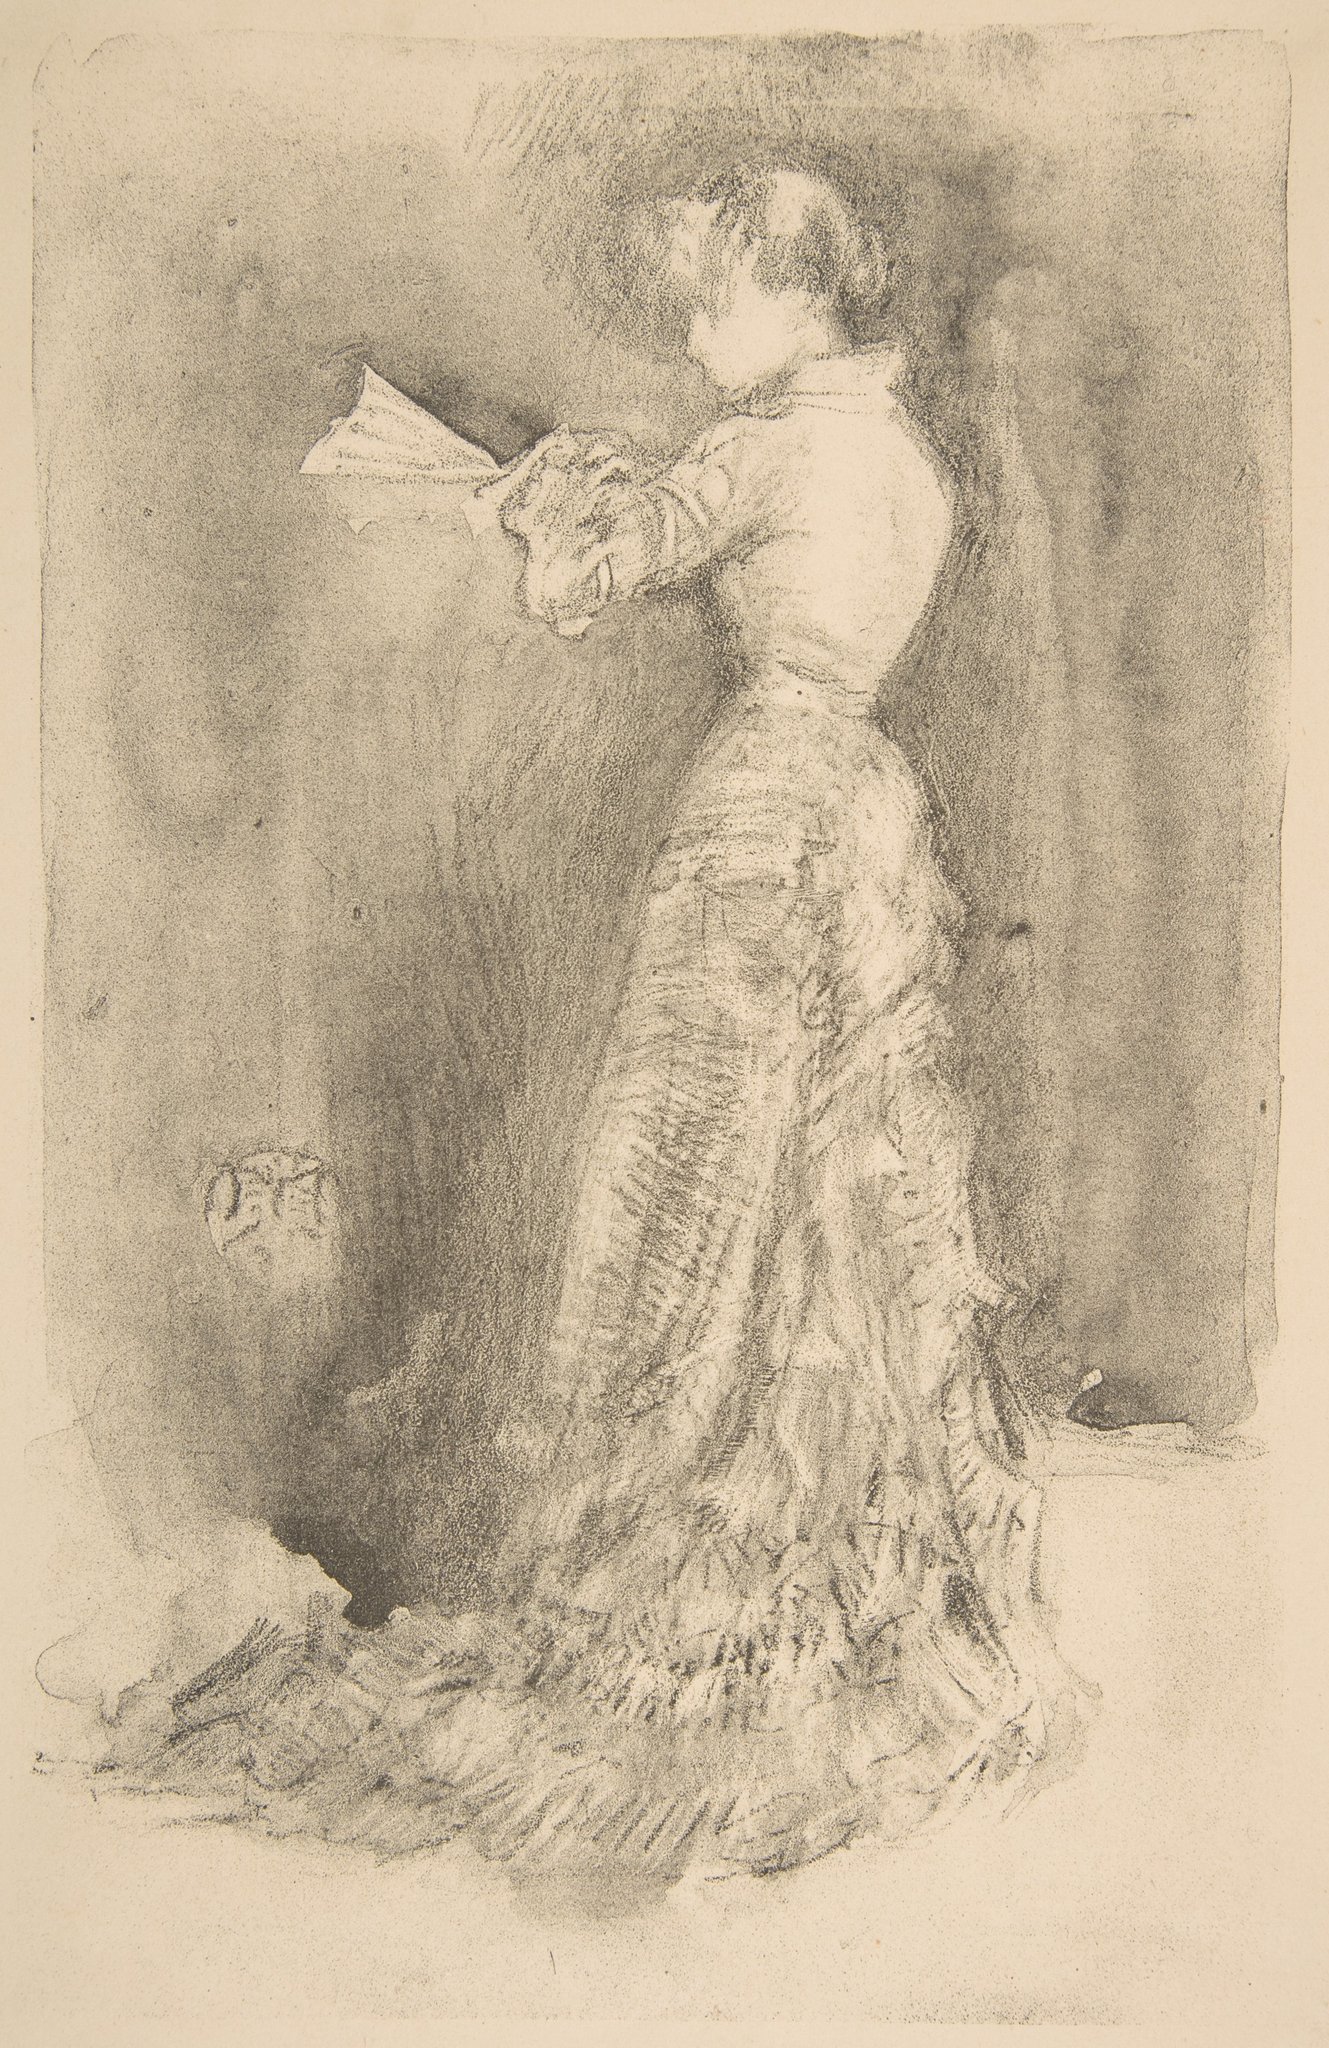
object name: print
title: The Toilet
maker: james mcneill whistler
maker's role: artist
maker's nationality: american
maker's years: 1834-1903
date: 1878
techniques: scraping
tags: girls